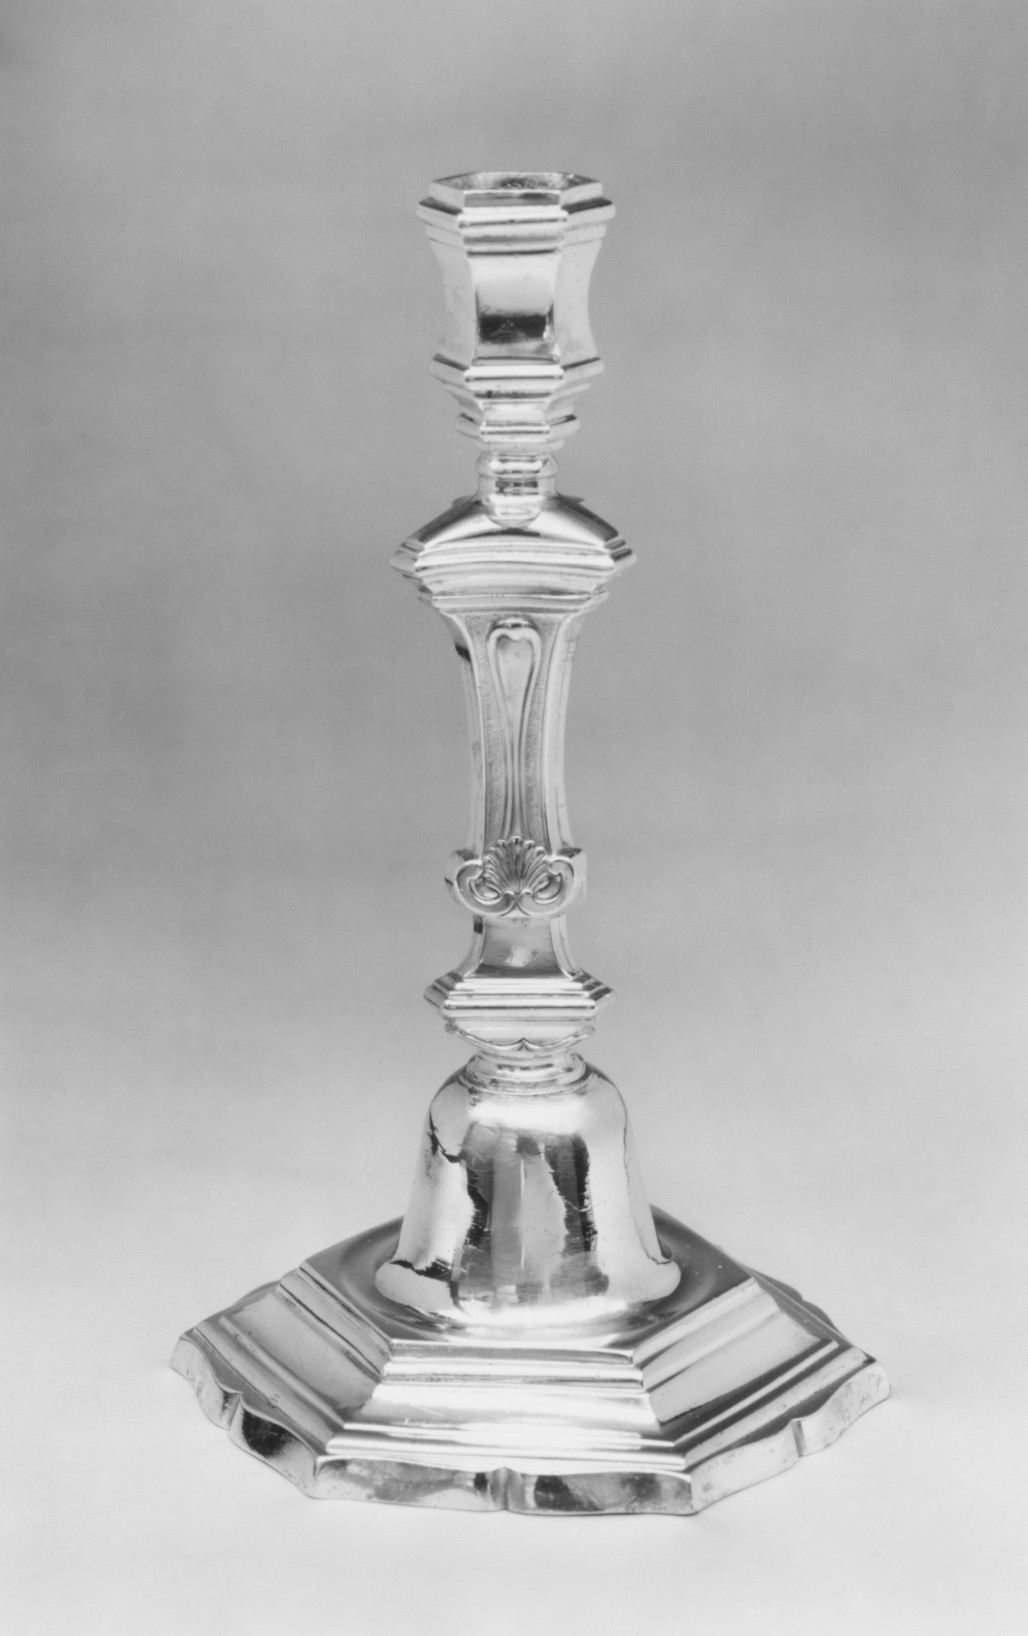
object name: candlestick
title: Candlestick (one of a pair)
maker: françois ii lacassaigne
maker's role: maker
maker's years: 1706-1803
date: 1751-1775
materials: silver